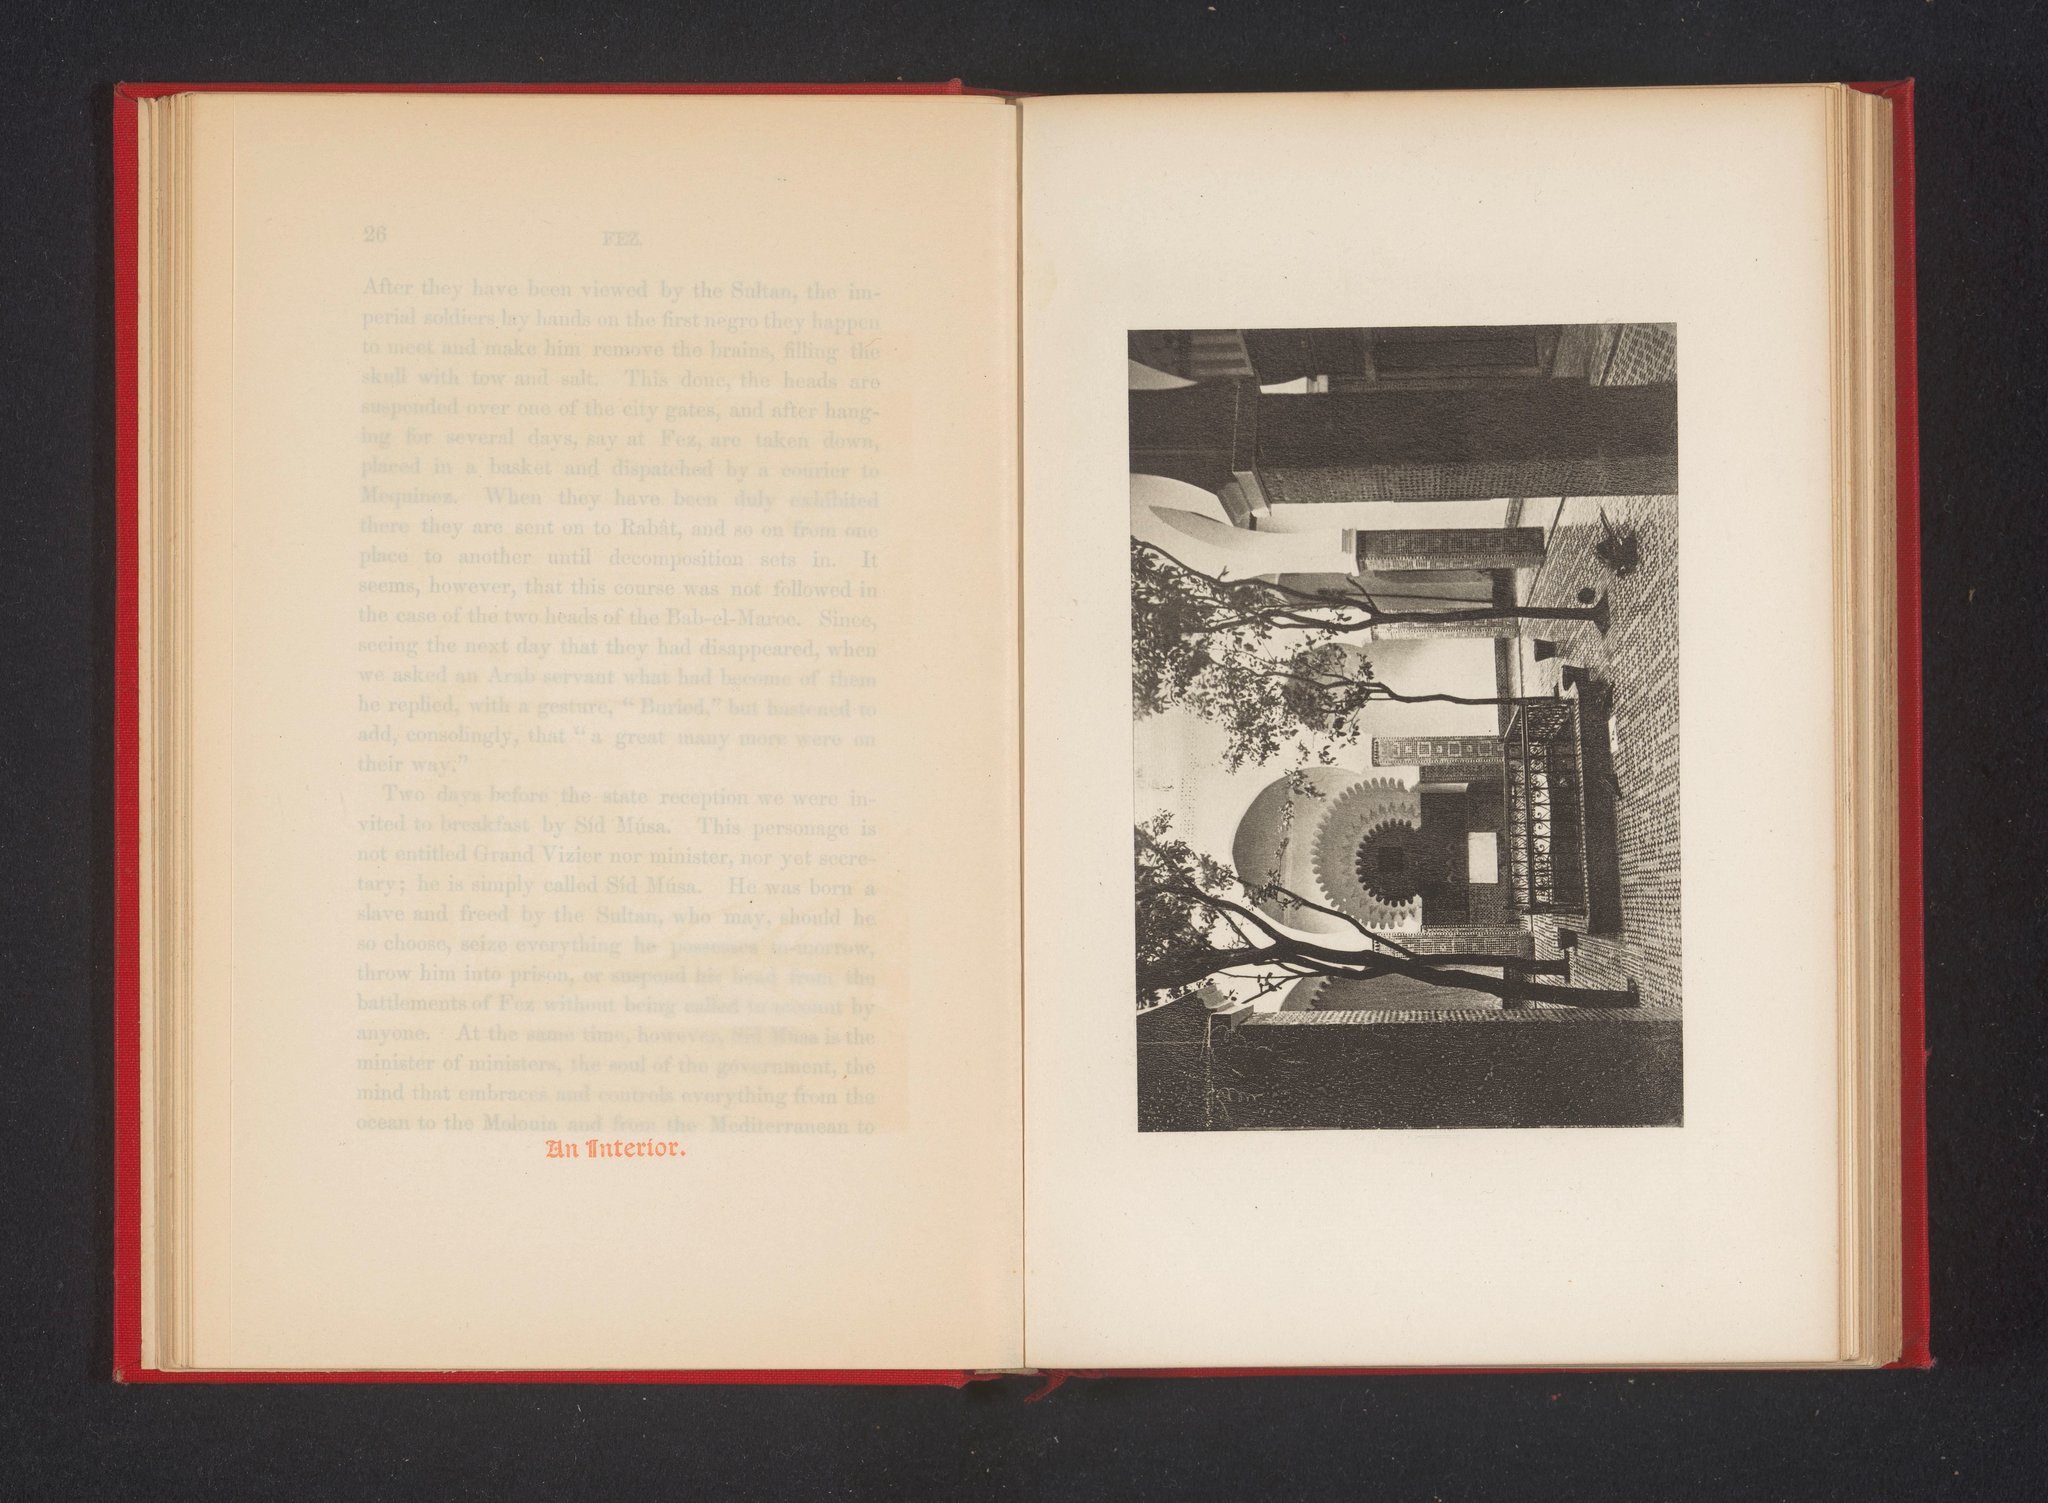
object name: photomechanical print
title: Binnenplaats van een woning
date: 1887-1897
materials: paper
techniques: photoaquatint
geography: morocco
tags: housing, façade of inner court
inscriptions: title: ‘An Interior.’